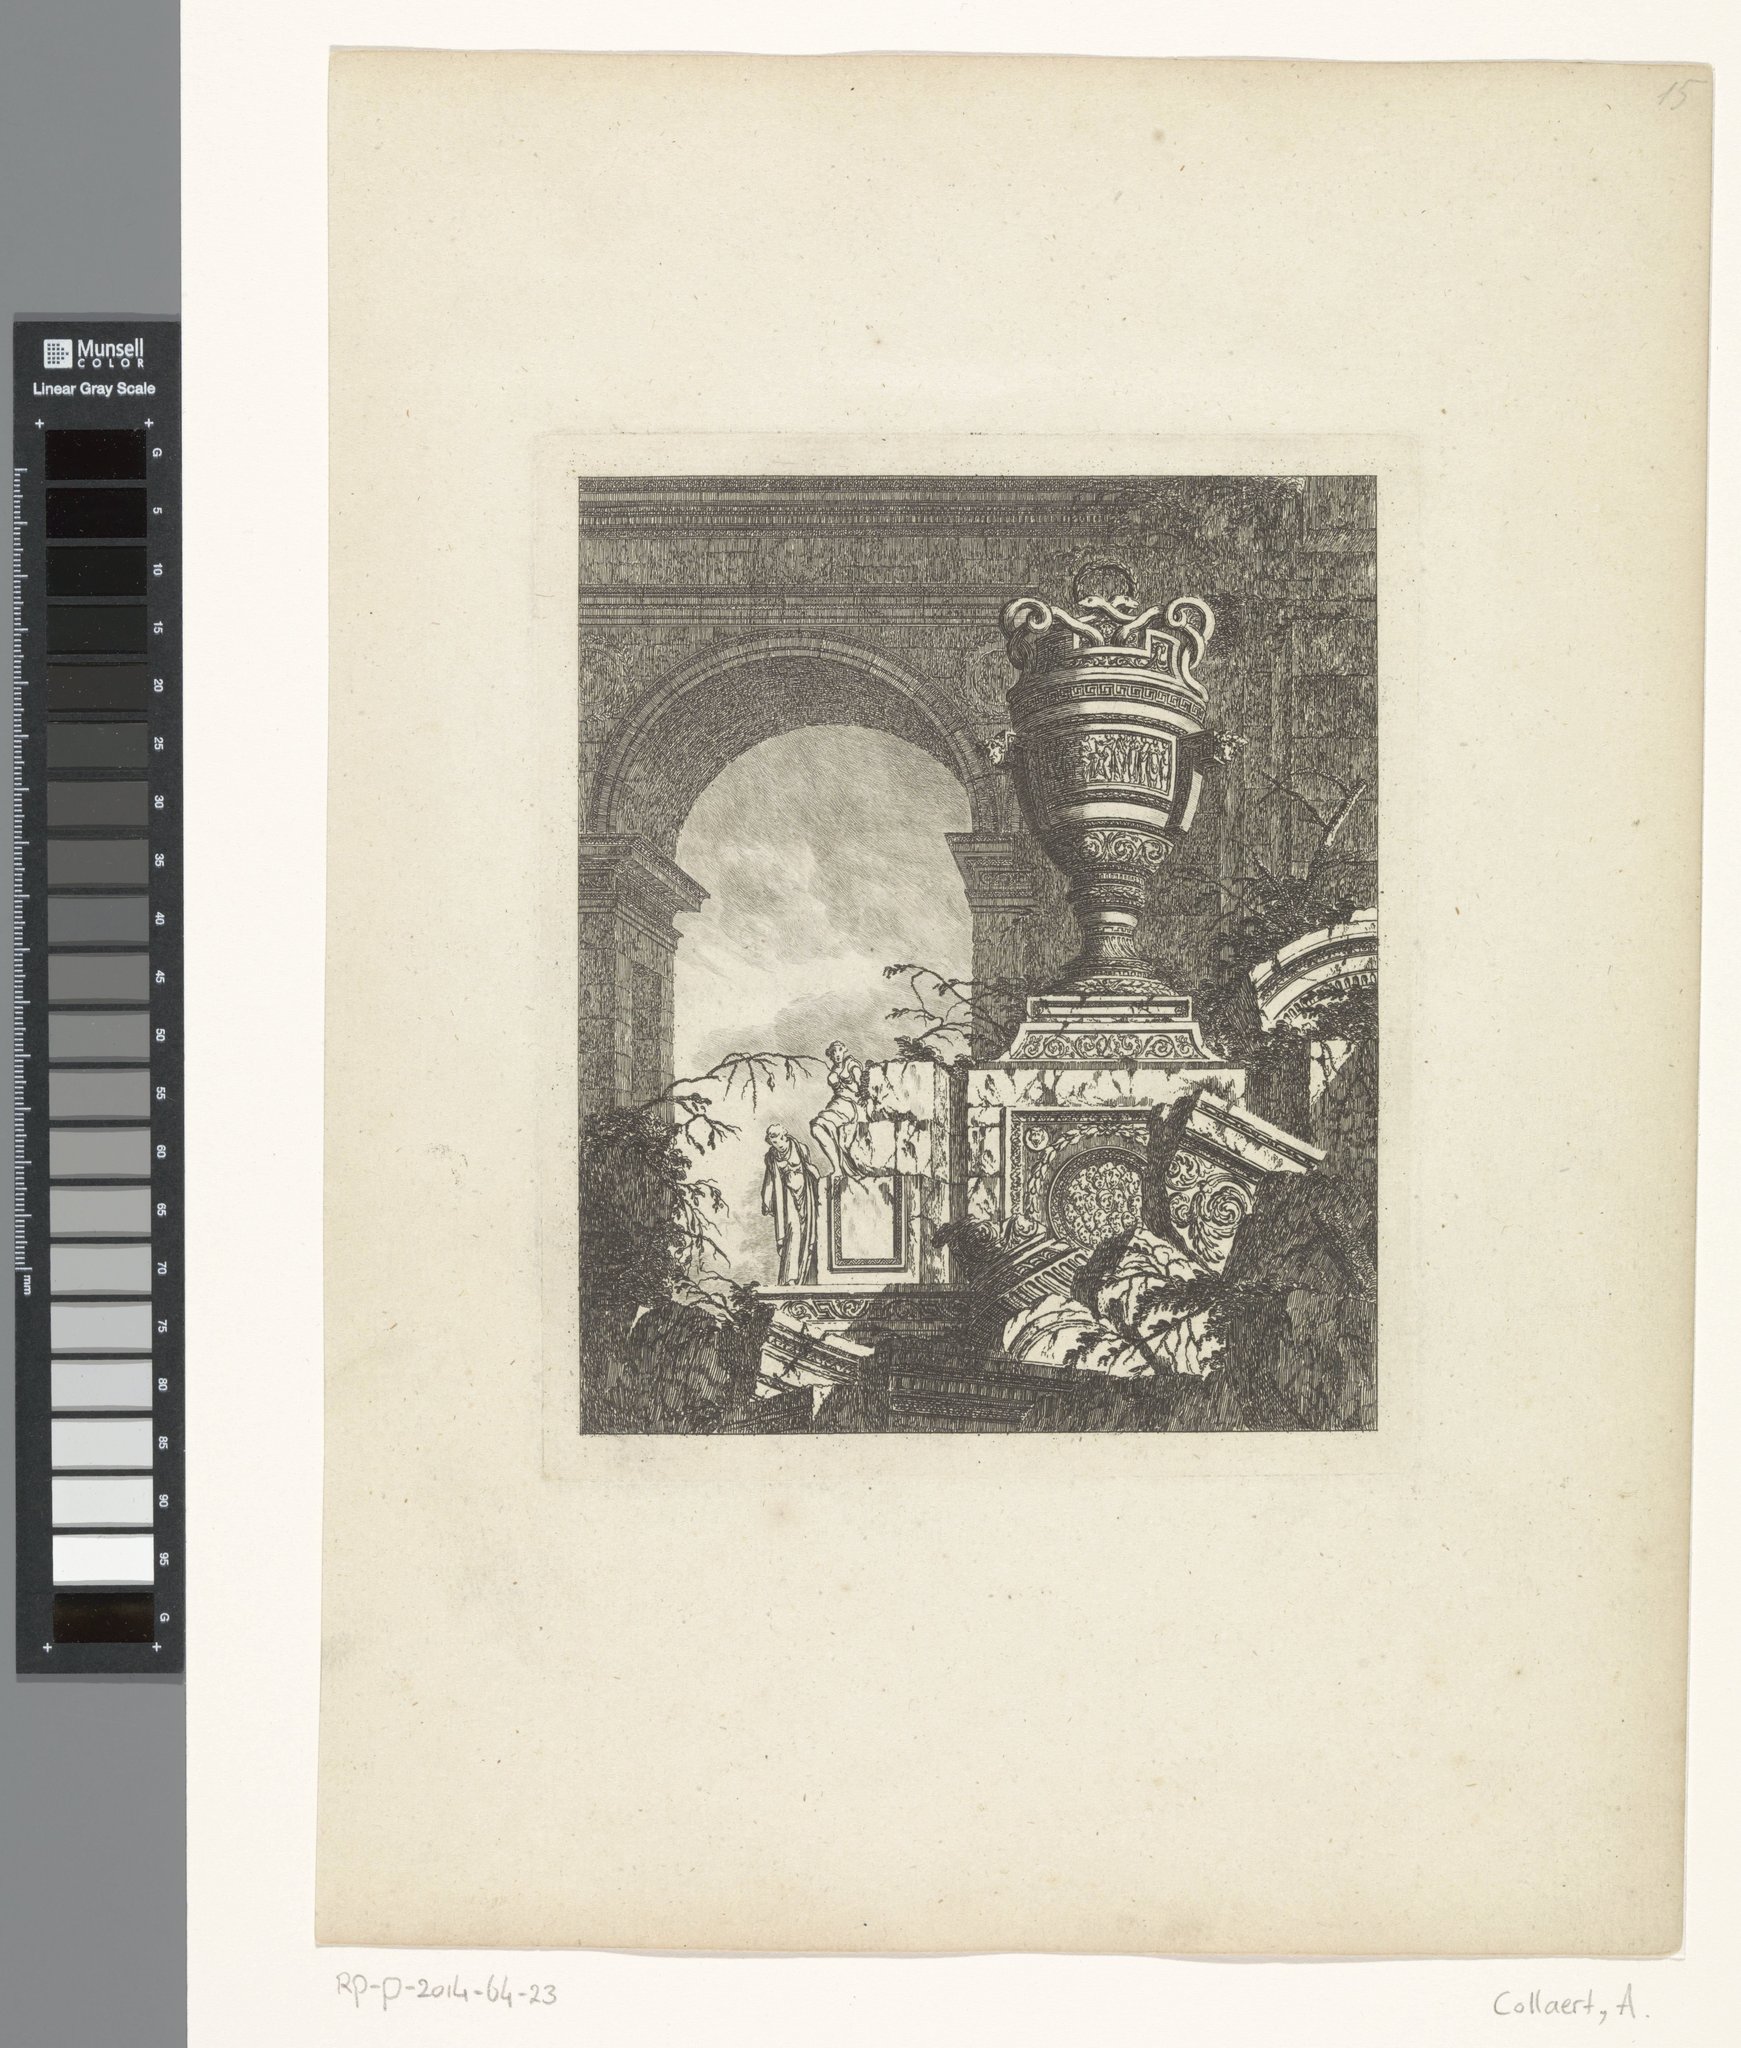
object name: print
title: Architectuurfantasie met groteske vaas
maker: jean laurent legeay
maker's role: print maker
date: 1767-1770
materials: paper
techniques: etching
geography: france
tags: vase ~ ornament, landscape with ruins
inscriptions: collector's mark: Lugt 2760, collector's mark: Lugt 2228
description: Architectuurfantasie met groteske vaas met slangen. Links een boog met twee figuren. Onderdeel van groep prenten afkomstig uit één van de vier series van vazen, ruïnes, tombes en fonteinen met in totaal ca. 25 bladen.